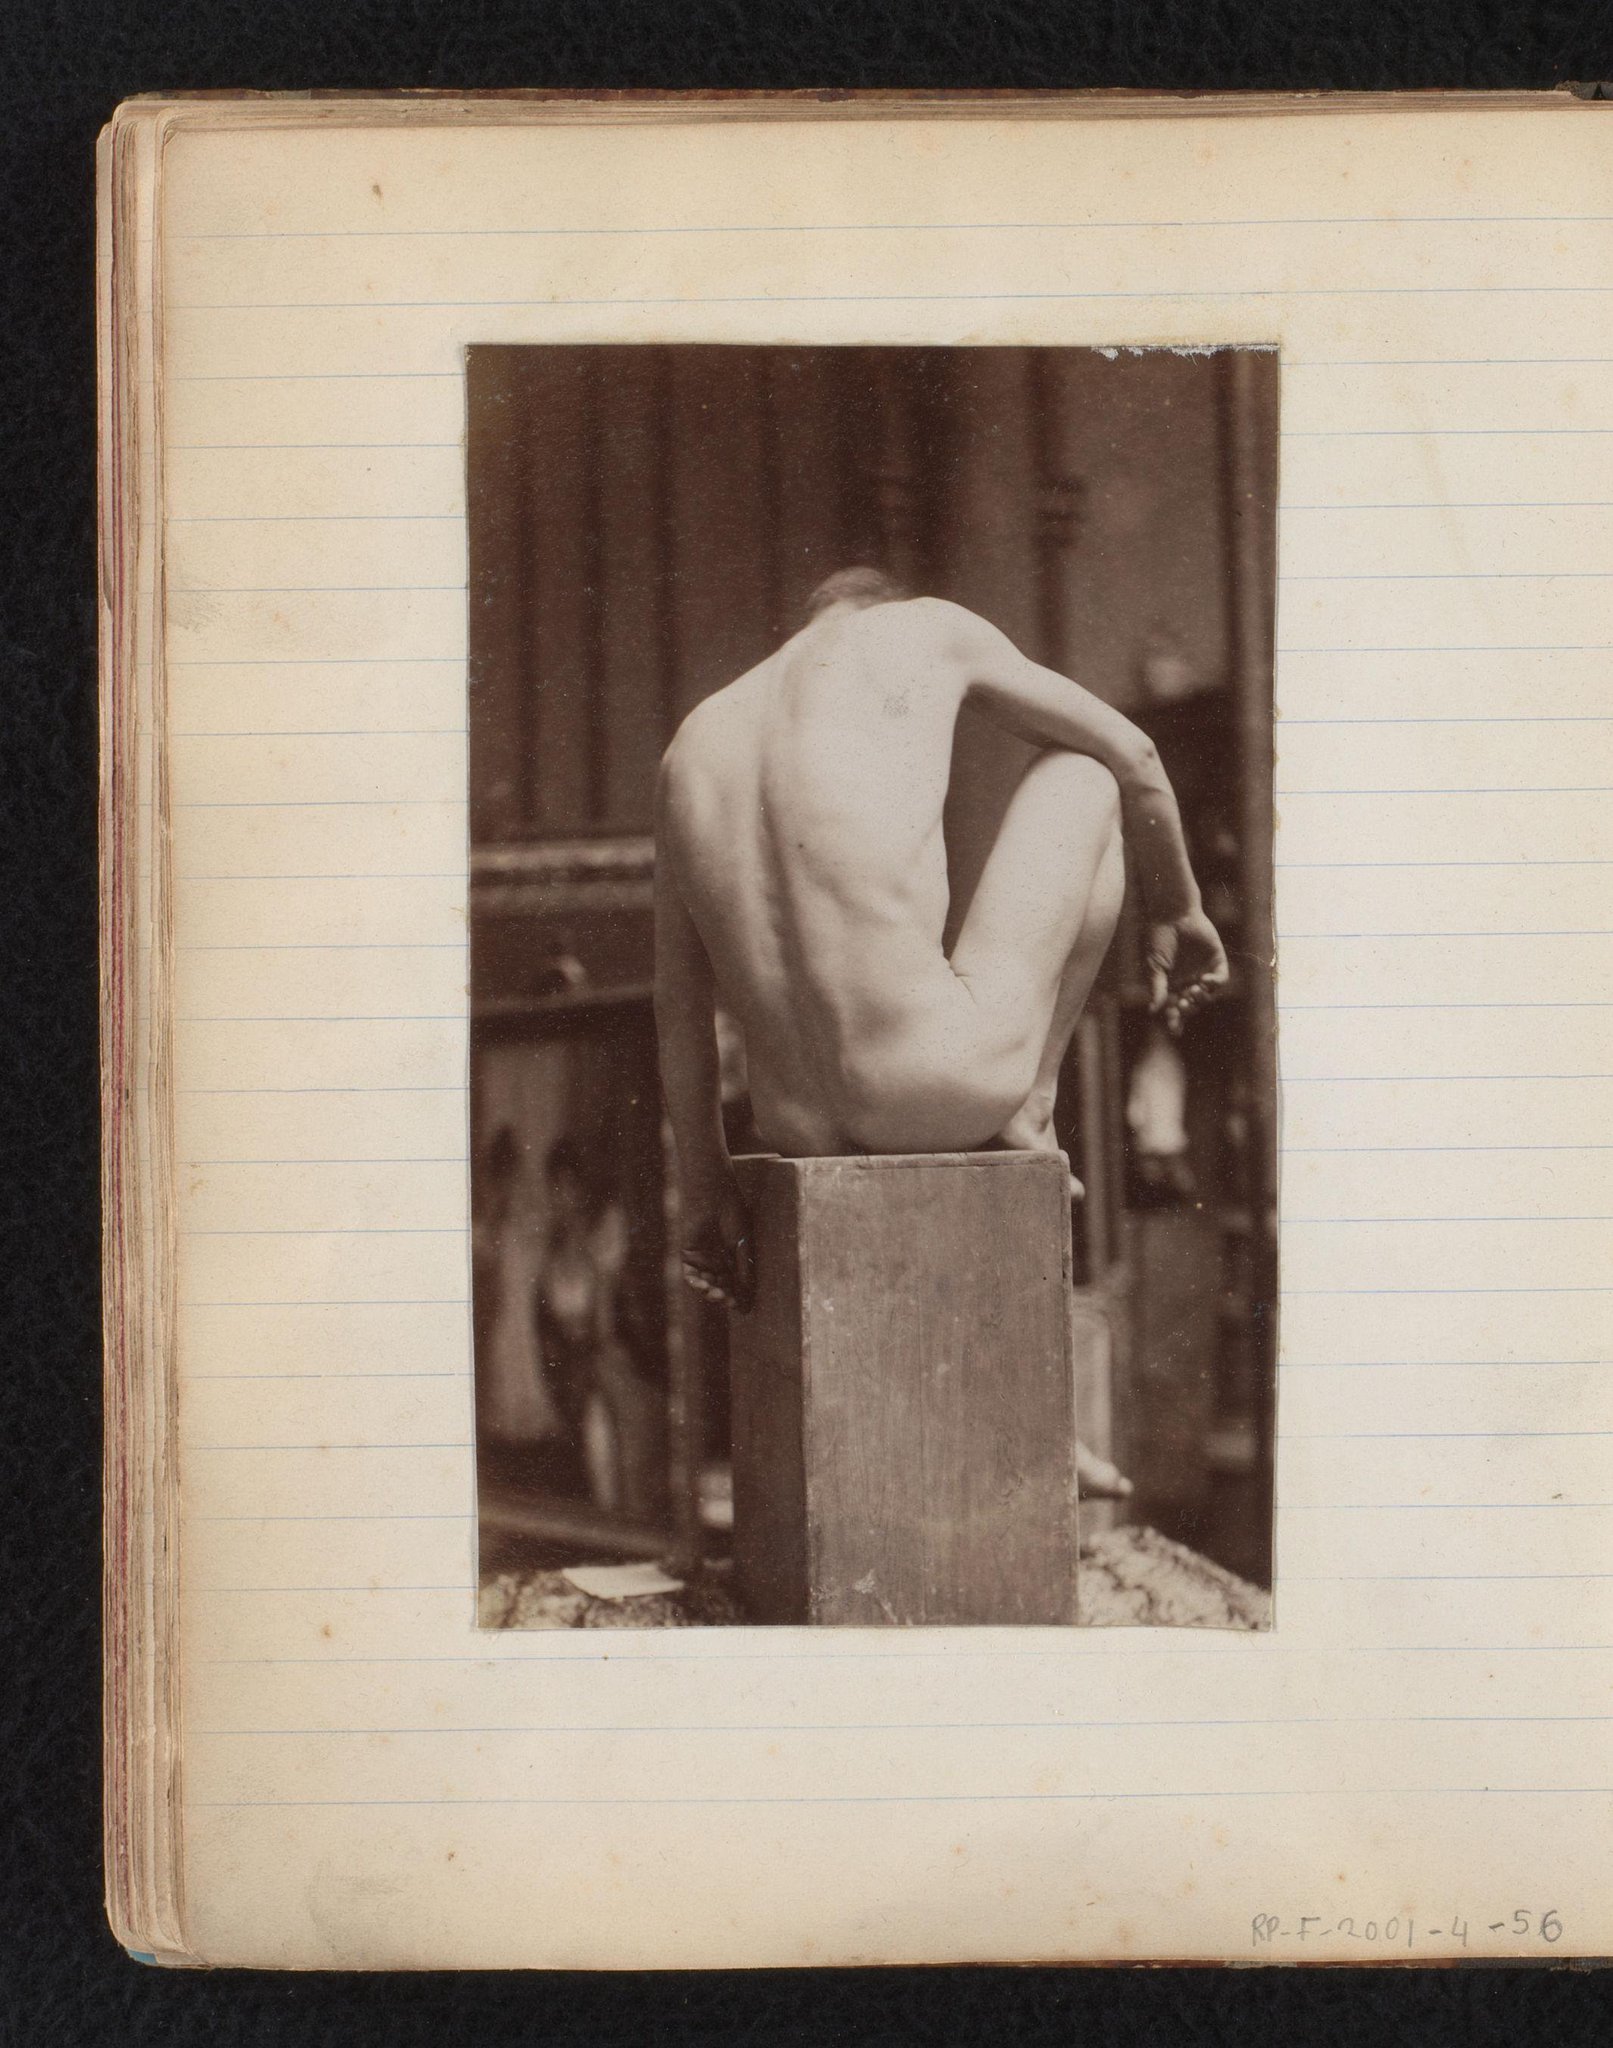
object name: album leaf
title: Studie van een mannelijk naaktmodel, zittend en op de rug gezien, in het atelier van Jacques de Lalaing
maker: jacques lalaing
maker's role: painter, sculptor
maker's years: 1858-1917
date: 1883-1914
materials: photographic support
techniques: albumen print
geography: brussels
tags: adult man, artist (in general) working from nude model, the (nude) human figure; 'corpo humano' (ripa) (+ back view)